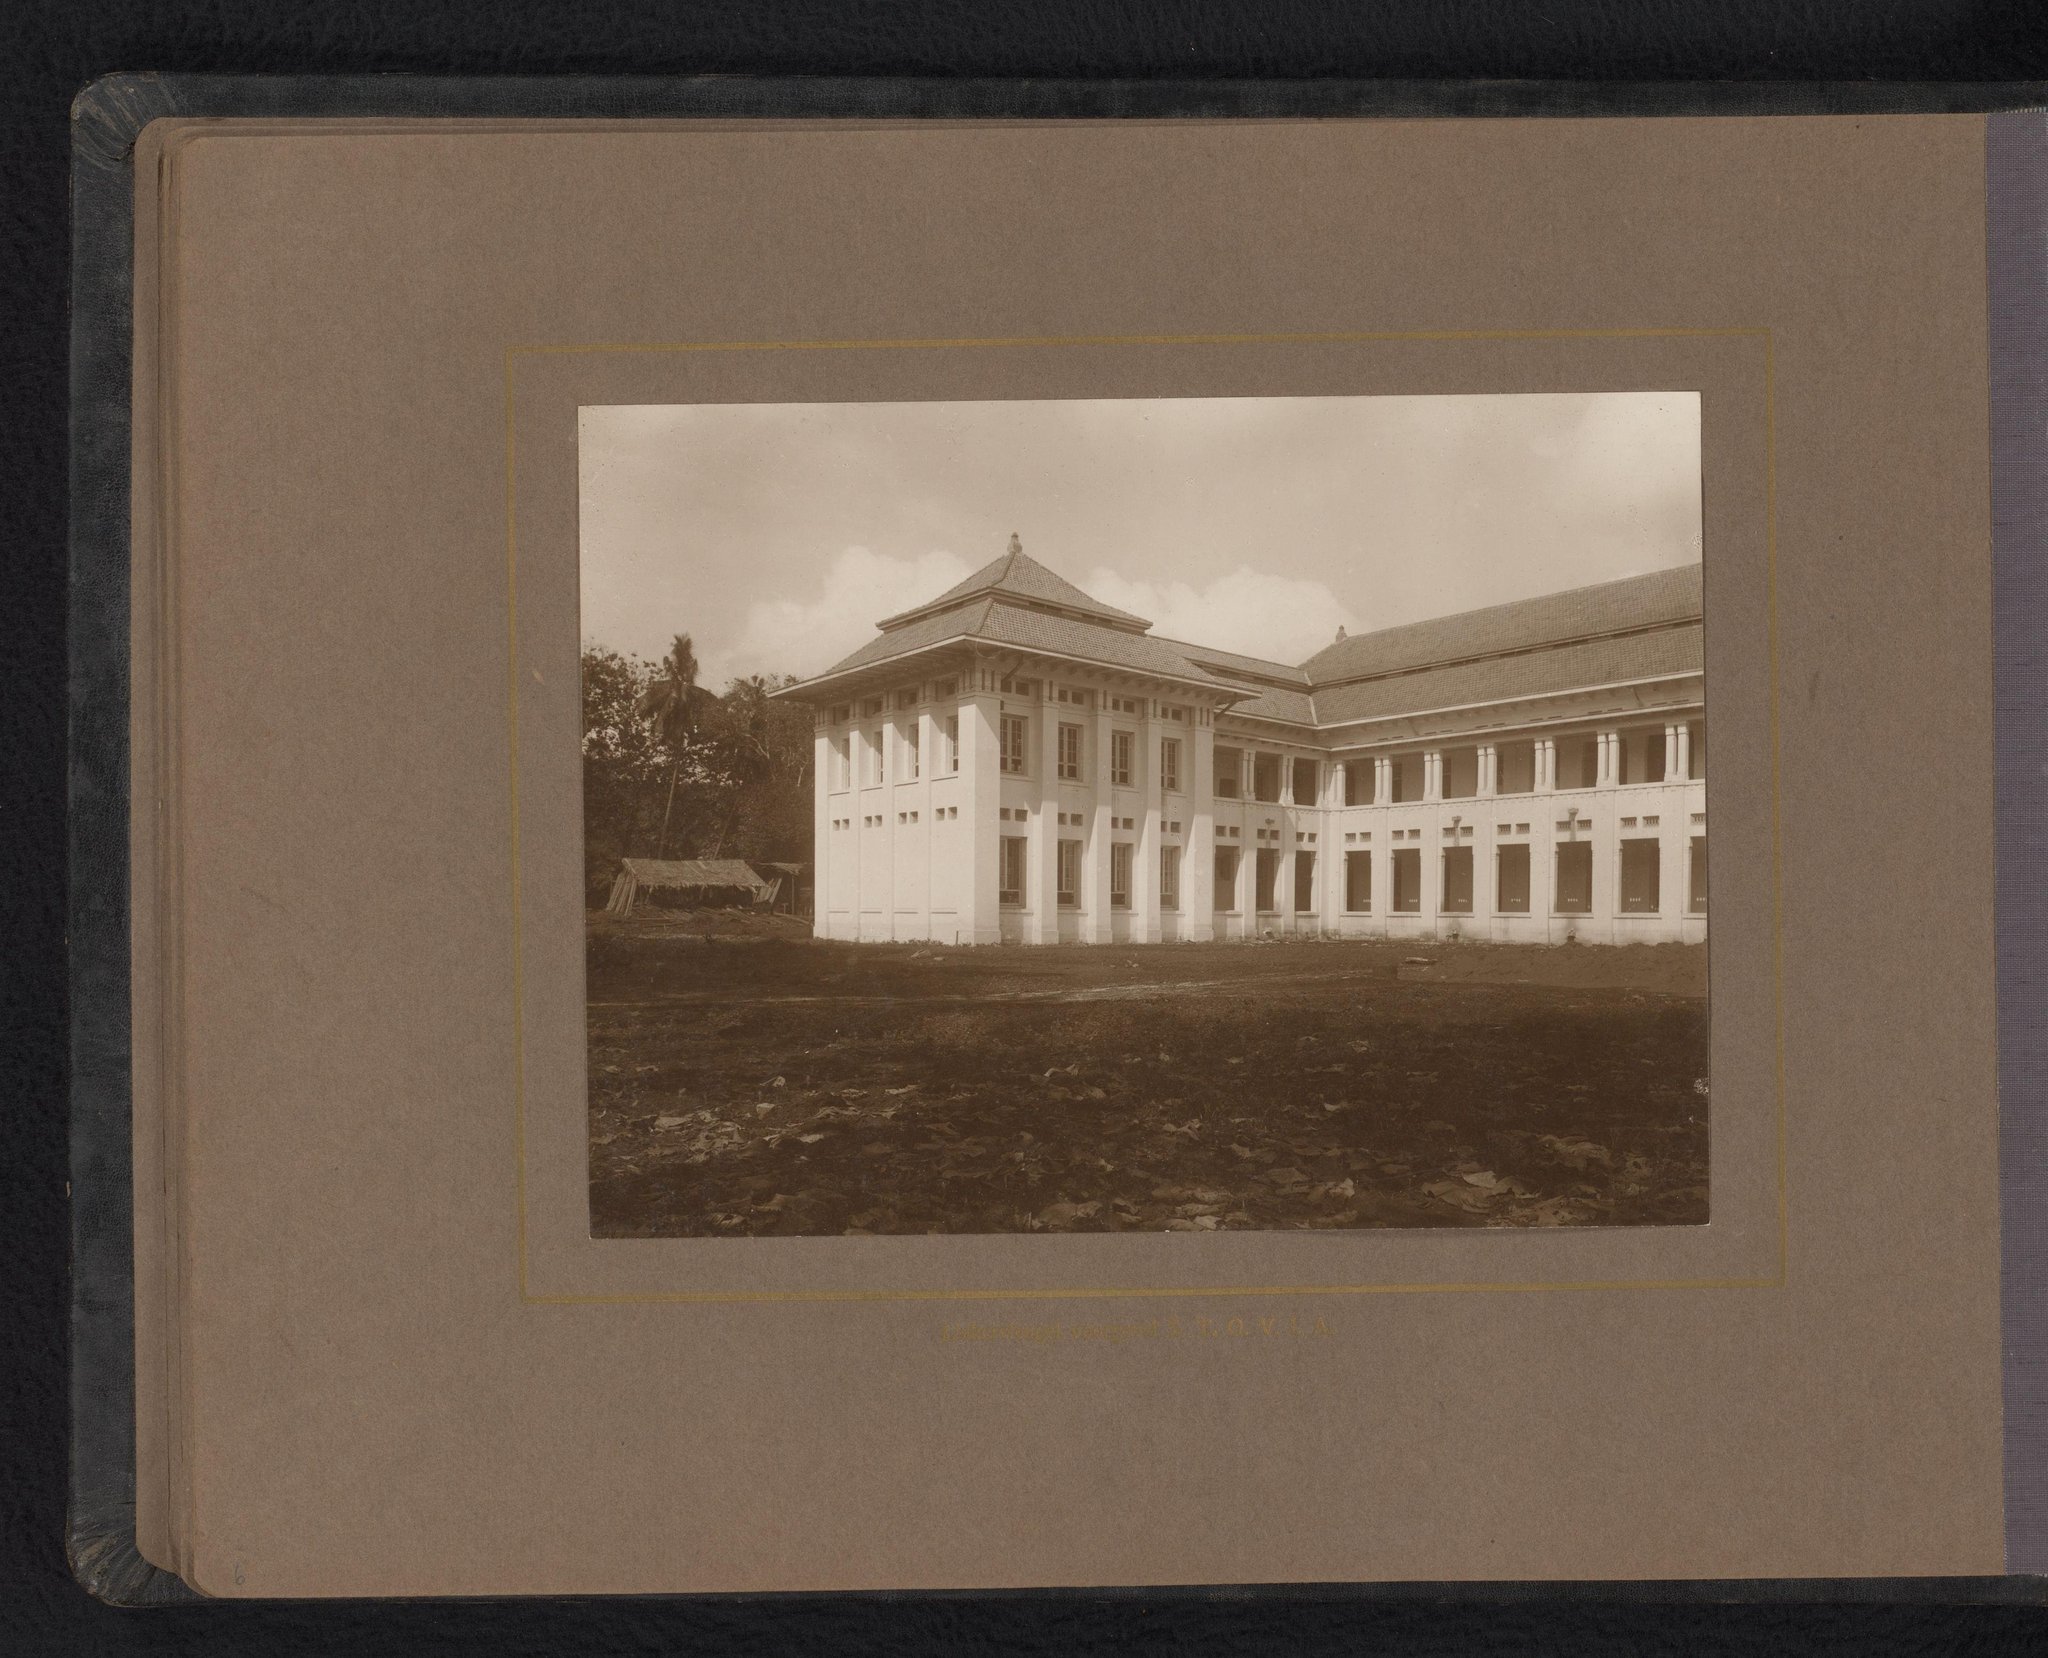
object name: photograph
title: Linkervleugel voorgevel S.T.O.V.I.A.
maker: Anonymous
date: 1918-1919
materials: photographic support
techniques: gelatin silver print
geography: batavia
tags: colonial system, further education (+ building ~ education, tuition), physician, doctor, batavia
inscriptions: inscription: ‘Linkervleugel voorgevel S.T.O.V.I.A.’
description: De linkervleugel van de voorgevel van het gebouw van de School tot Opleiding van Inlandse Artsen (STOVIA) in Batavia, in aanbouw. Onderdeel van het fotoalbum van de Eerste Waterstaatsafdeling op West-Java 22 maart 1915 - 30 juli 1919.